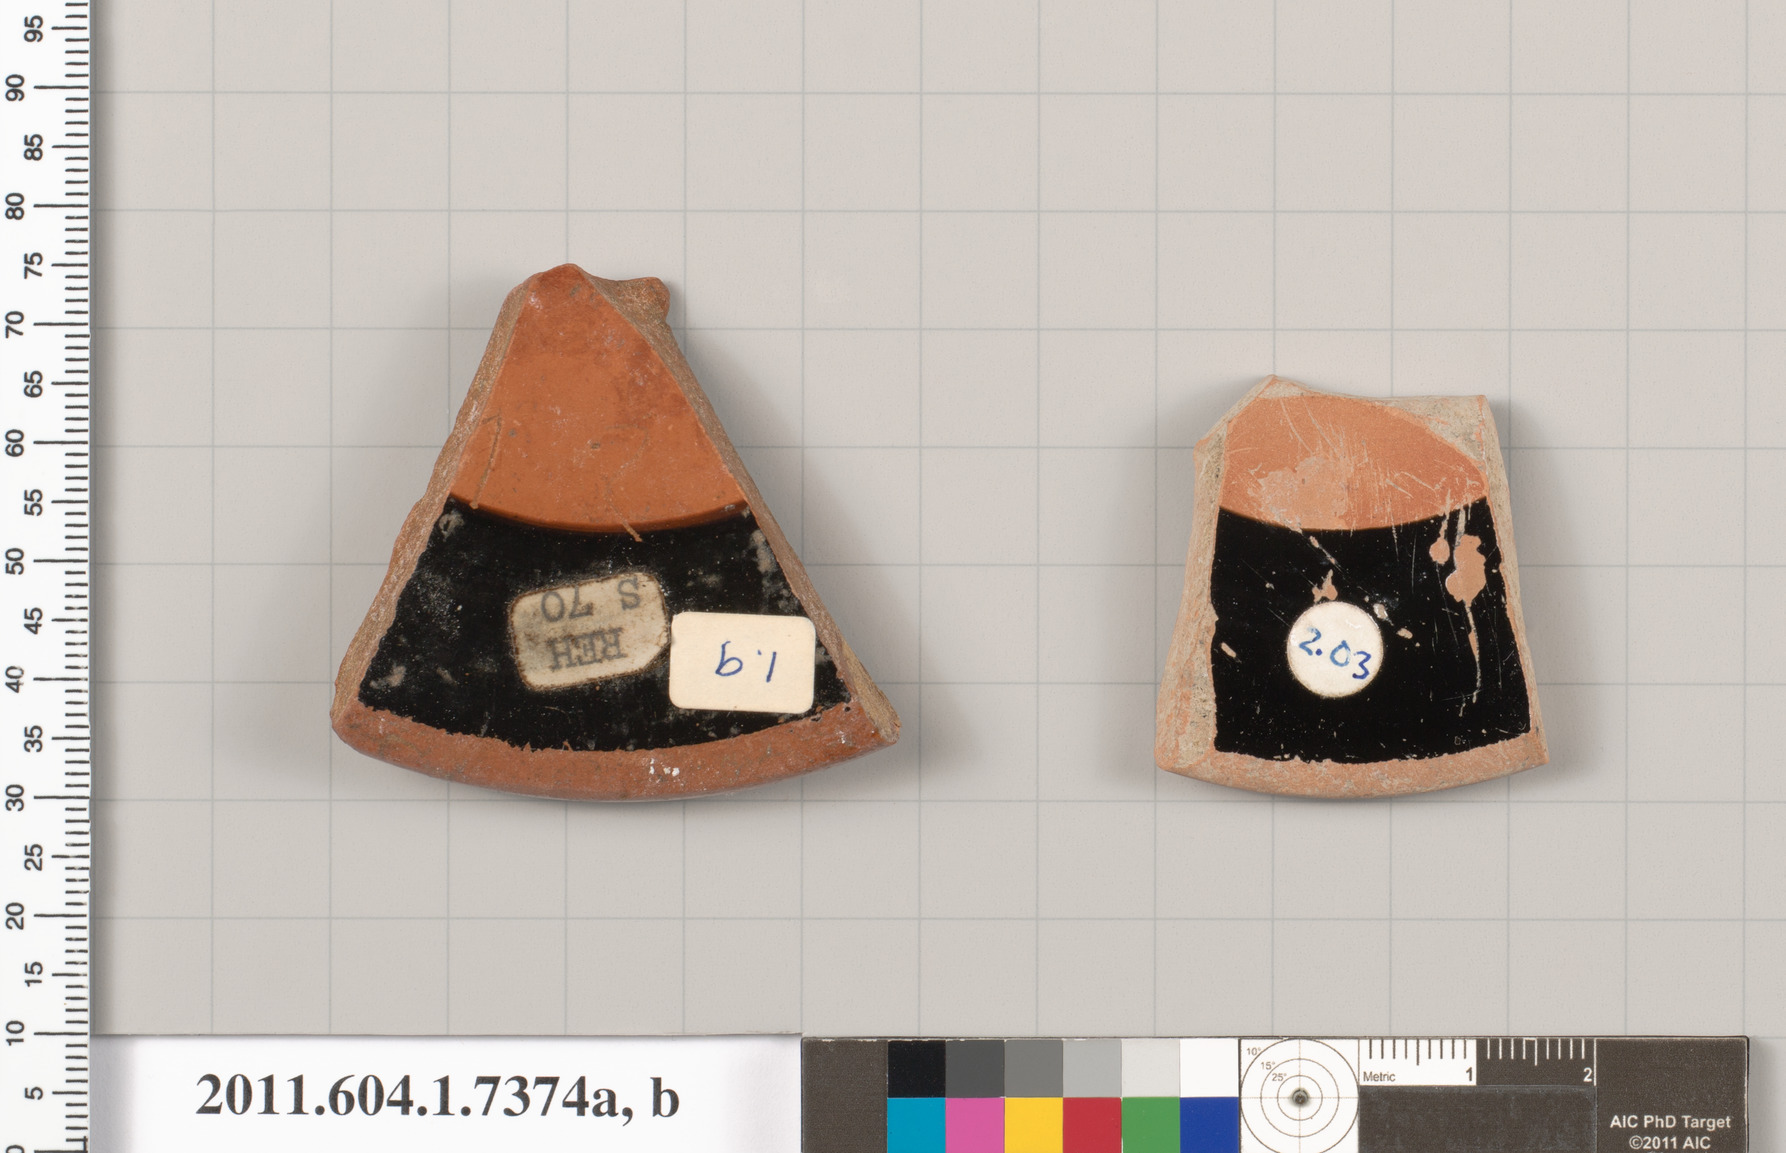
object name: kylix fragment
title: Terracotta fragments of kylikes (drinking cups)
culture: greek, attic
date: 500-480 BCE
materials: terracotta